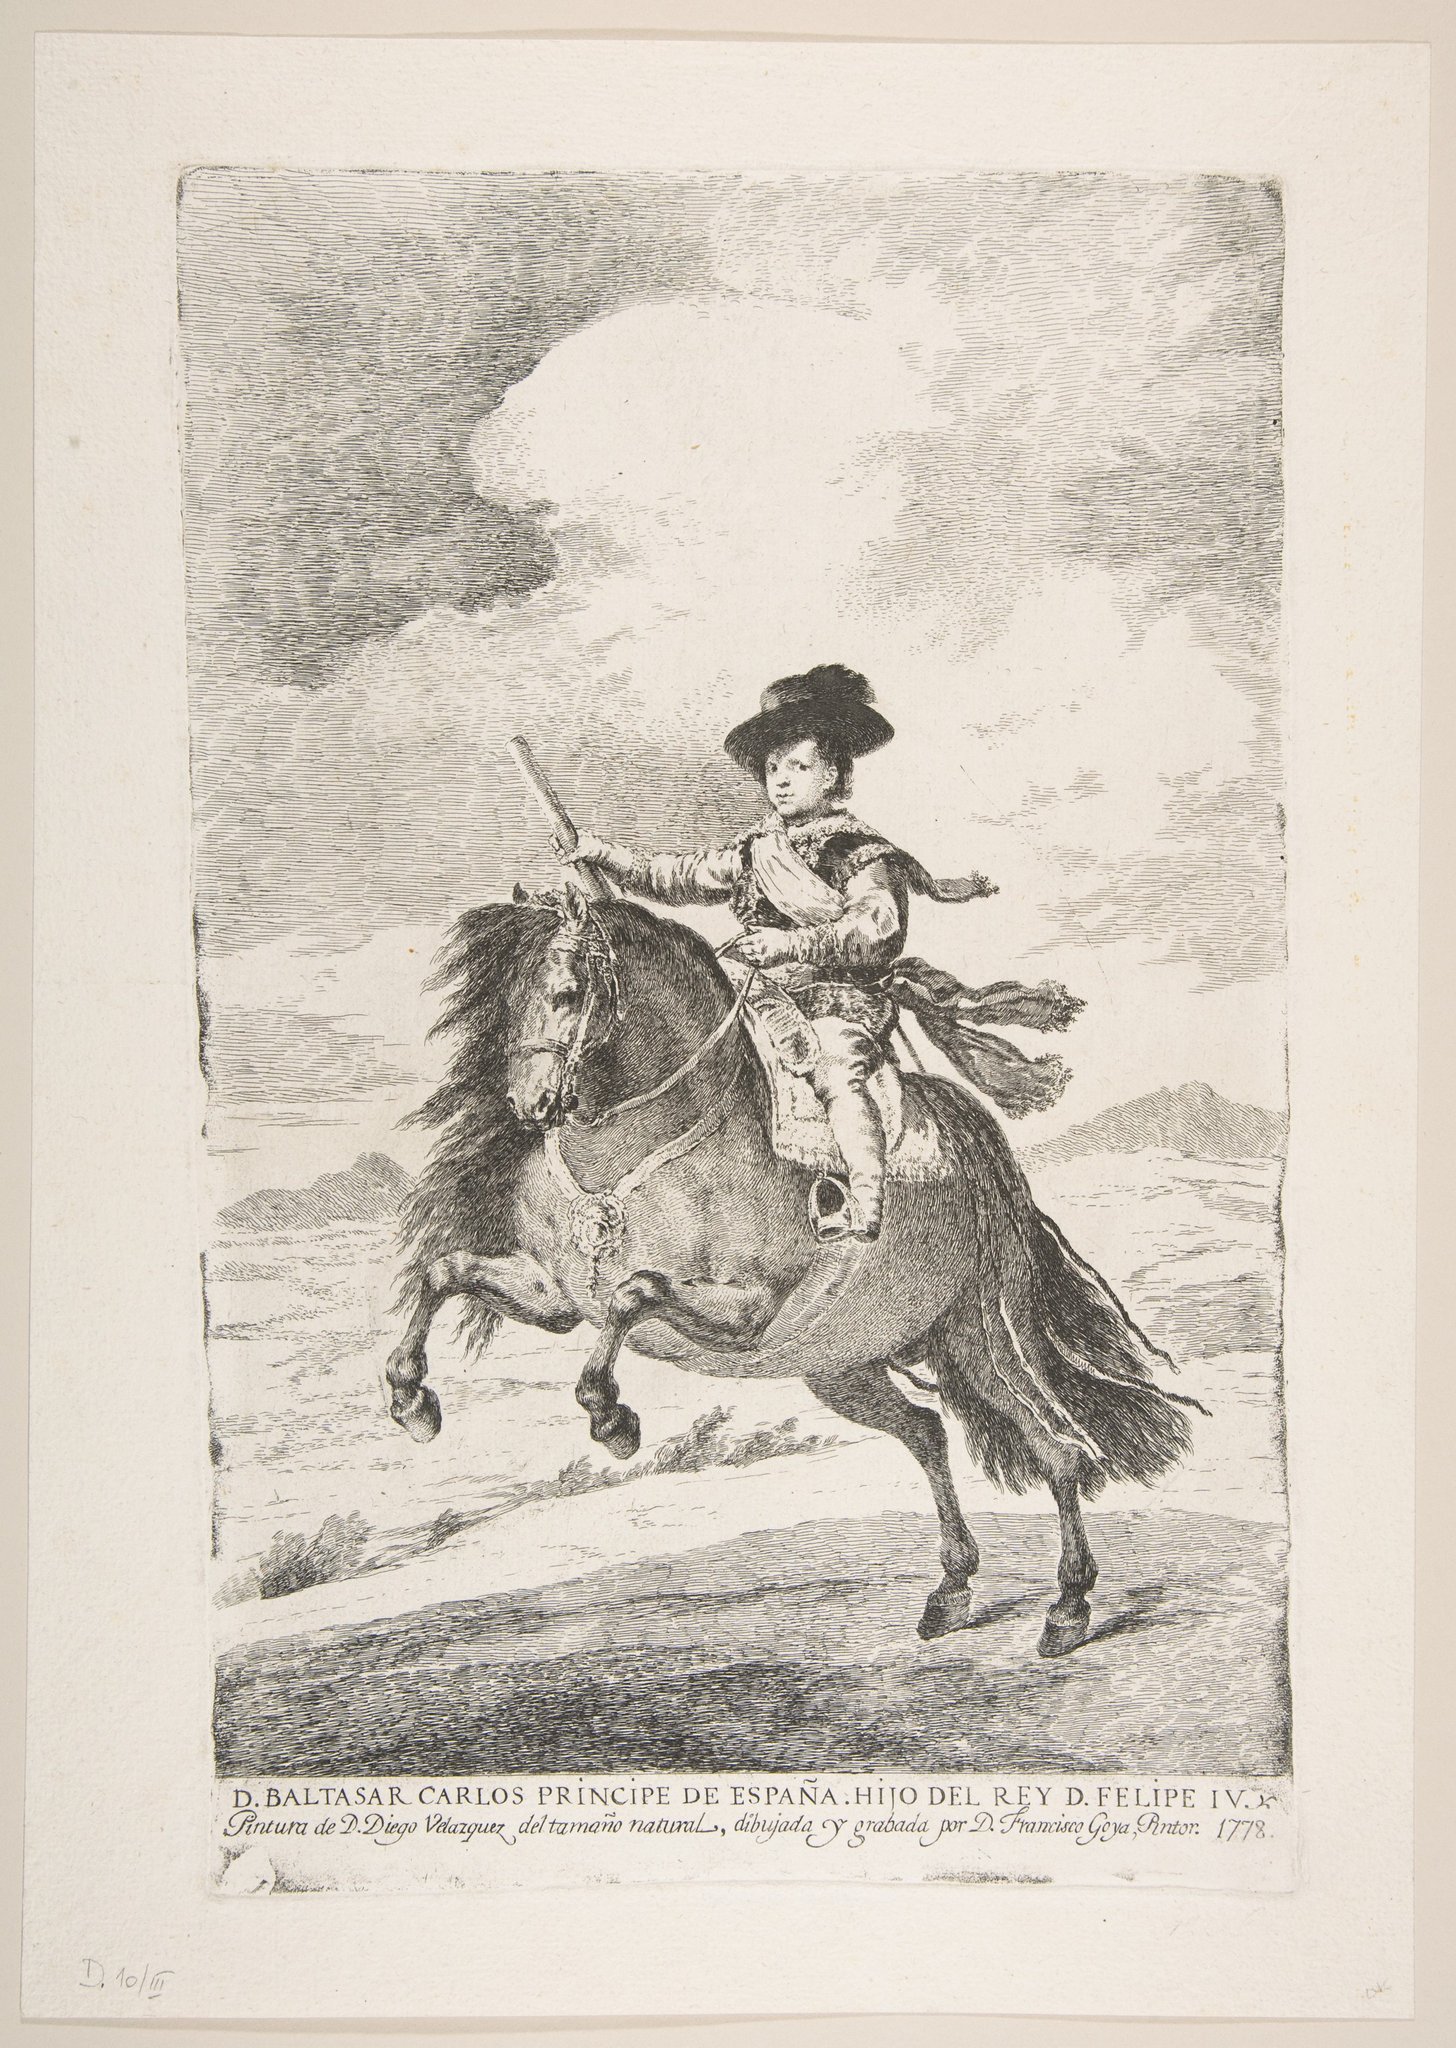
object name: print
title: Baltasar Carlos on horseback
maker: goya (francisco de goya y lucientes)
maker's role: artist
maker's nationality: spanish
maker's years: 1746-1828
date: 1778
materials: ink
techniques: drypoint, etching, printing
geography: spain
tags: princes,horses